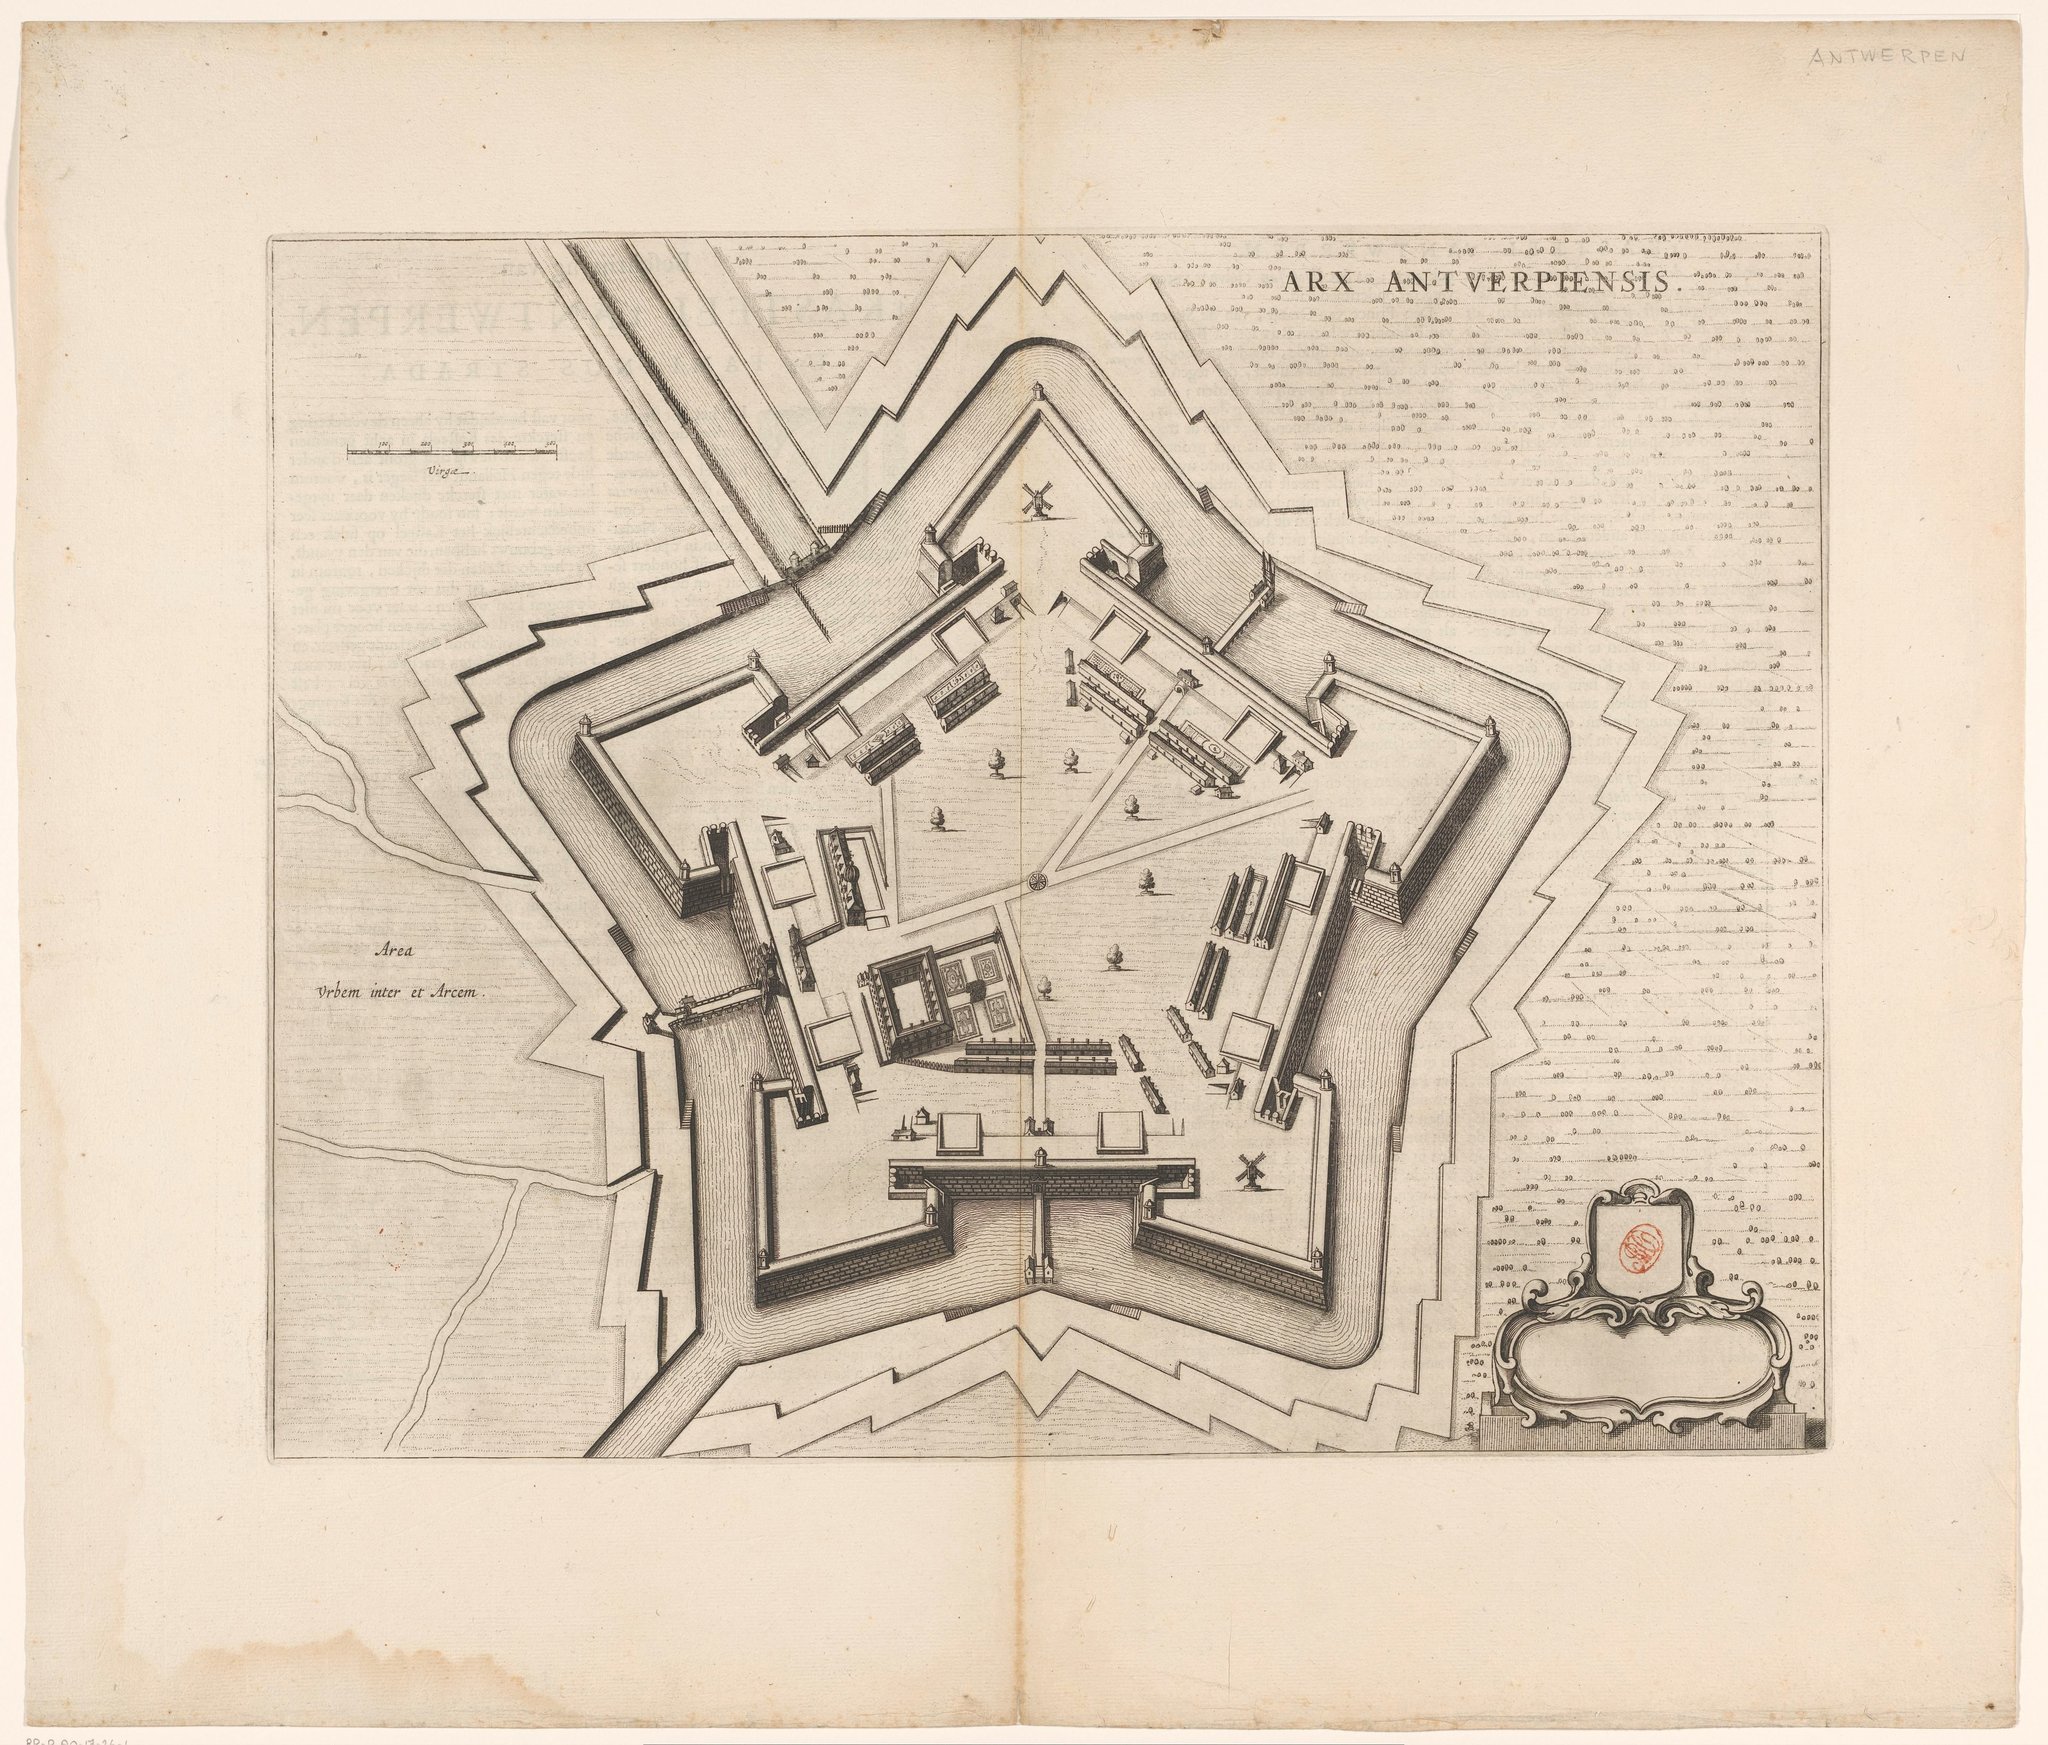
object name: print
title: Arx Antverpiensis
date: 1652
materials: paper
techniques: engraving, etching, letterpress printing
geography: amsterdam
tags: fortified city, maps of cities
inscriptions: collector's mark: Lugt 195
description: Prent gebruikt in sommige exemplaren van: Blaeu, Johannes Willemszoon. Toonneel der steden van de Vereenighde Nederlanden. 2 delen. Amsterdam: Johannes Willemszoon Blaeu, 1652, dl. 2.